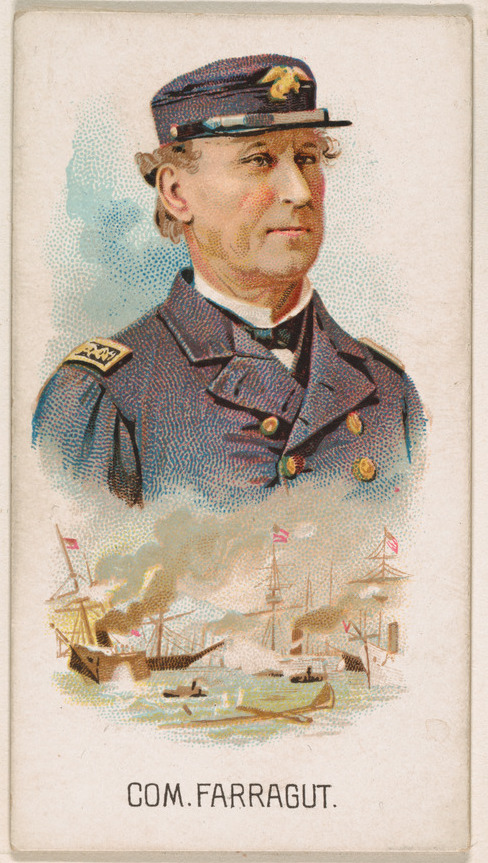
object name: print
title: Com. Farragut, from Leaders series (N222) issued by Kinney Bros.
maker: kinney brothers tobacco company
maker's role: publisher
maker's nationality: american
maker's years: 1869-2011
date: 1888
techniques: color lithograph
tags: men